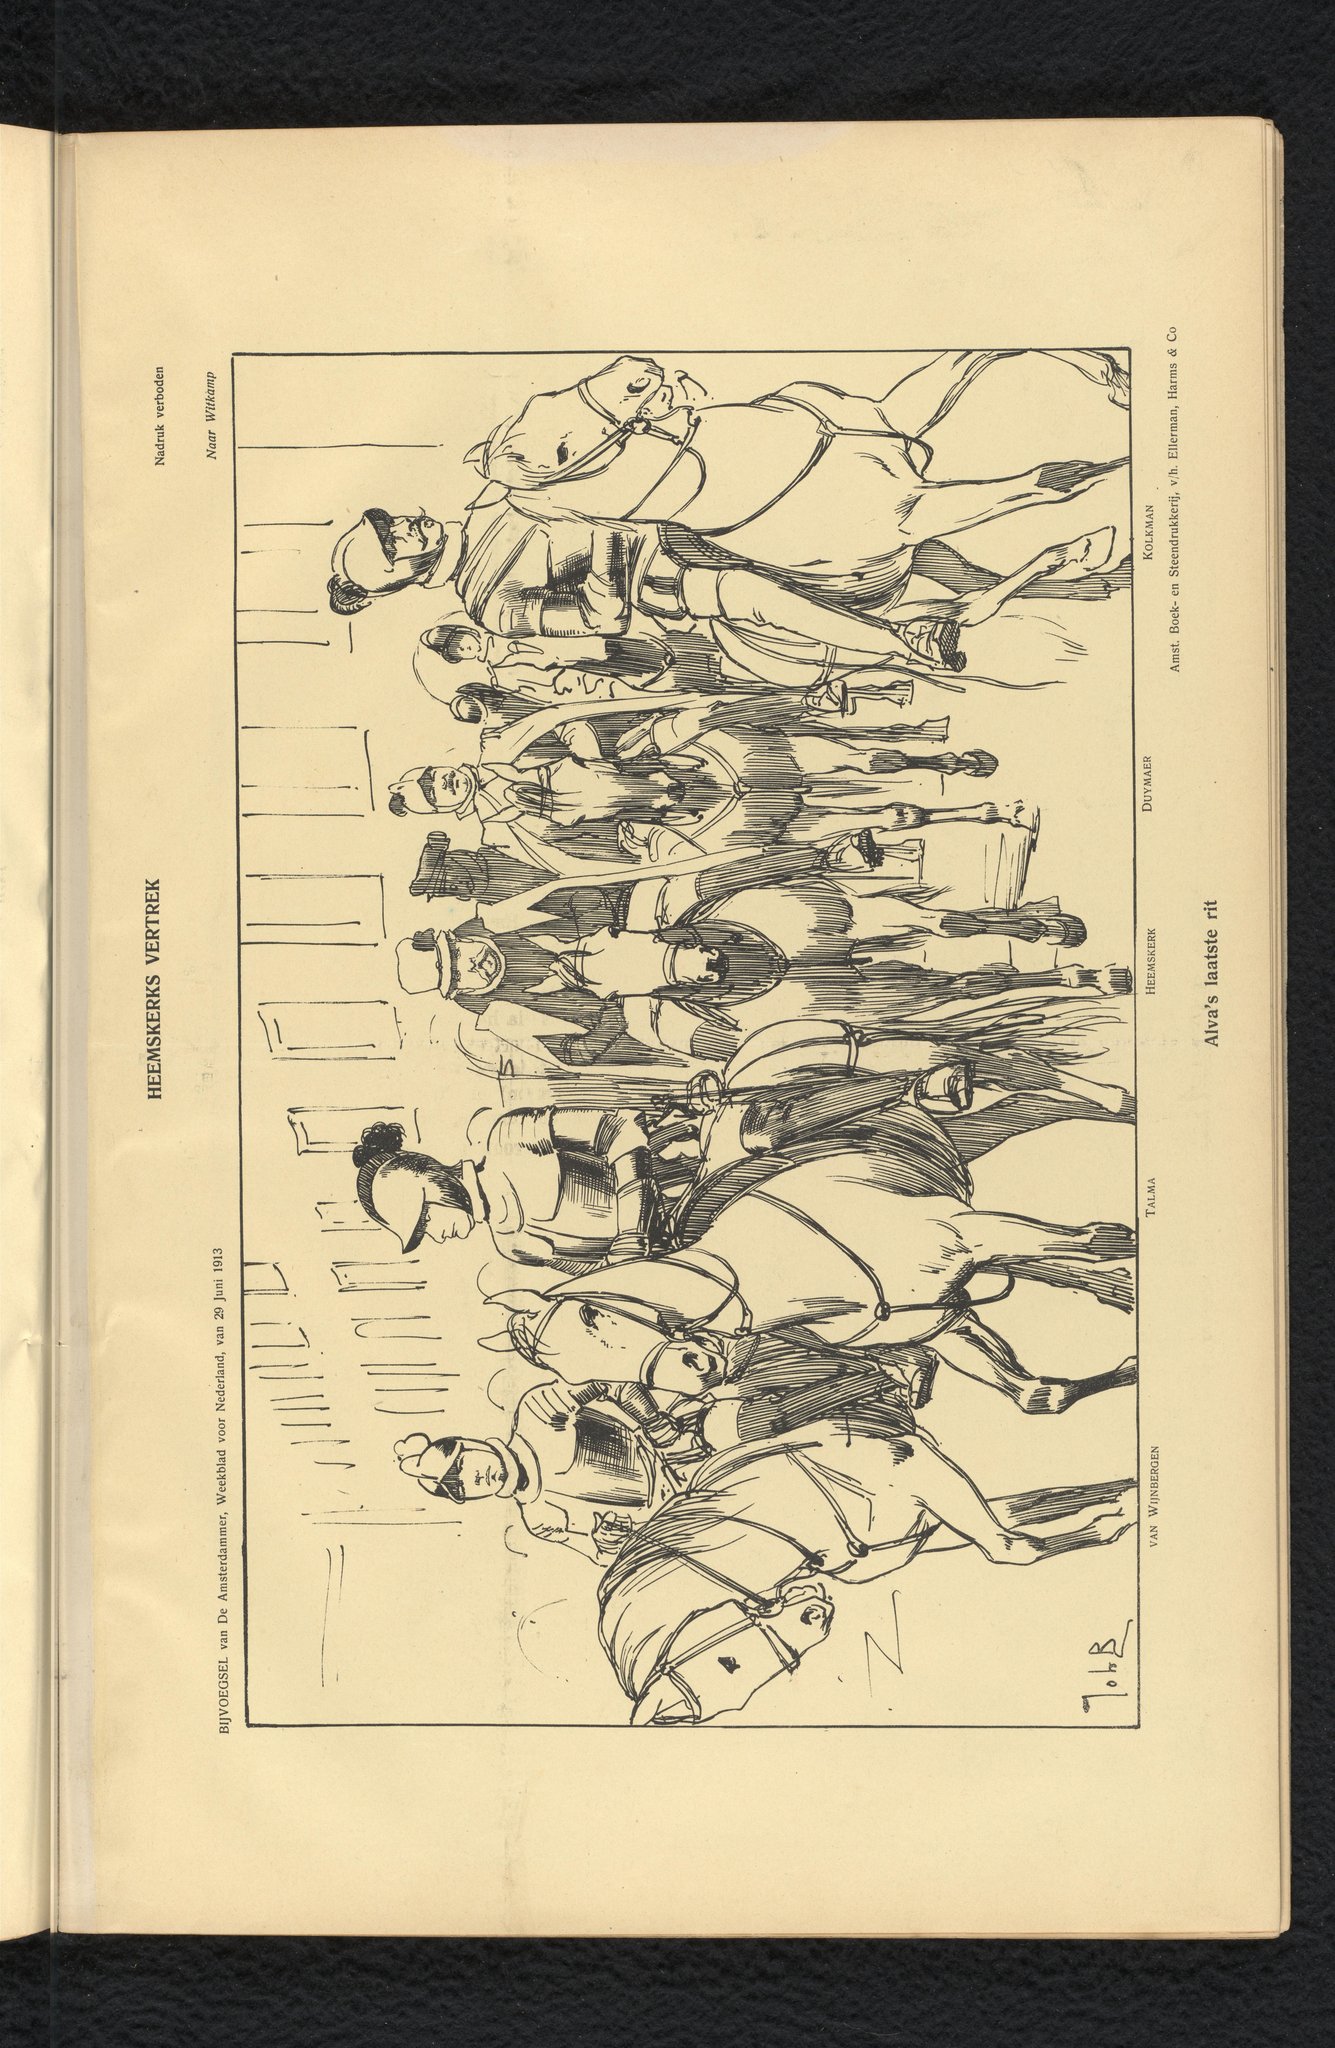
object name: cartoon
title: Heemskerks vertrek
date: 1913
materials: paper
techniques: lithograph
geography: netherlands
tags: amsterdam, utrecht, fernando álvarez de toledo (3rd duke of alba), dordrecht, the hague, politician, departure ~ travelling, political caricatures and satires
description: Het vertrek van premier Heemskerk na de Tweede Kamerverkiezingen van juni 1913 voorgesteld als 'Alva's laatste rit'. Heemskerk wordt uitgeleide gedaan door de ruiters Van Wijnbergen, Talma, Duymaer en Kolkman. Pastiche op het schilderij 'Alva's laatste rit langs den Buitenkant te Amsterdam' van Nicolaas van der Waay en Ernst Witkamp.